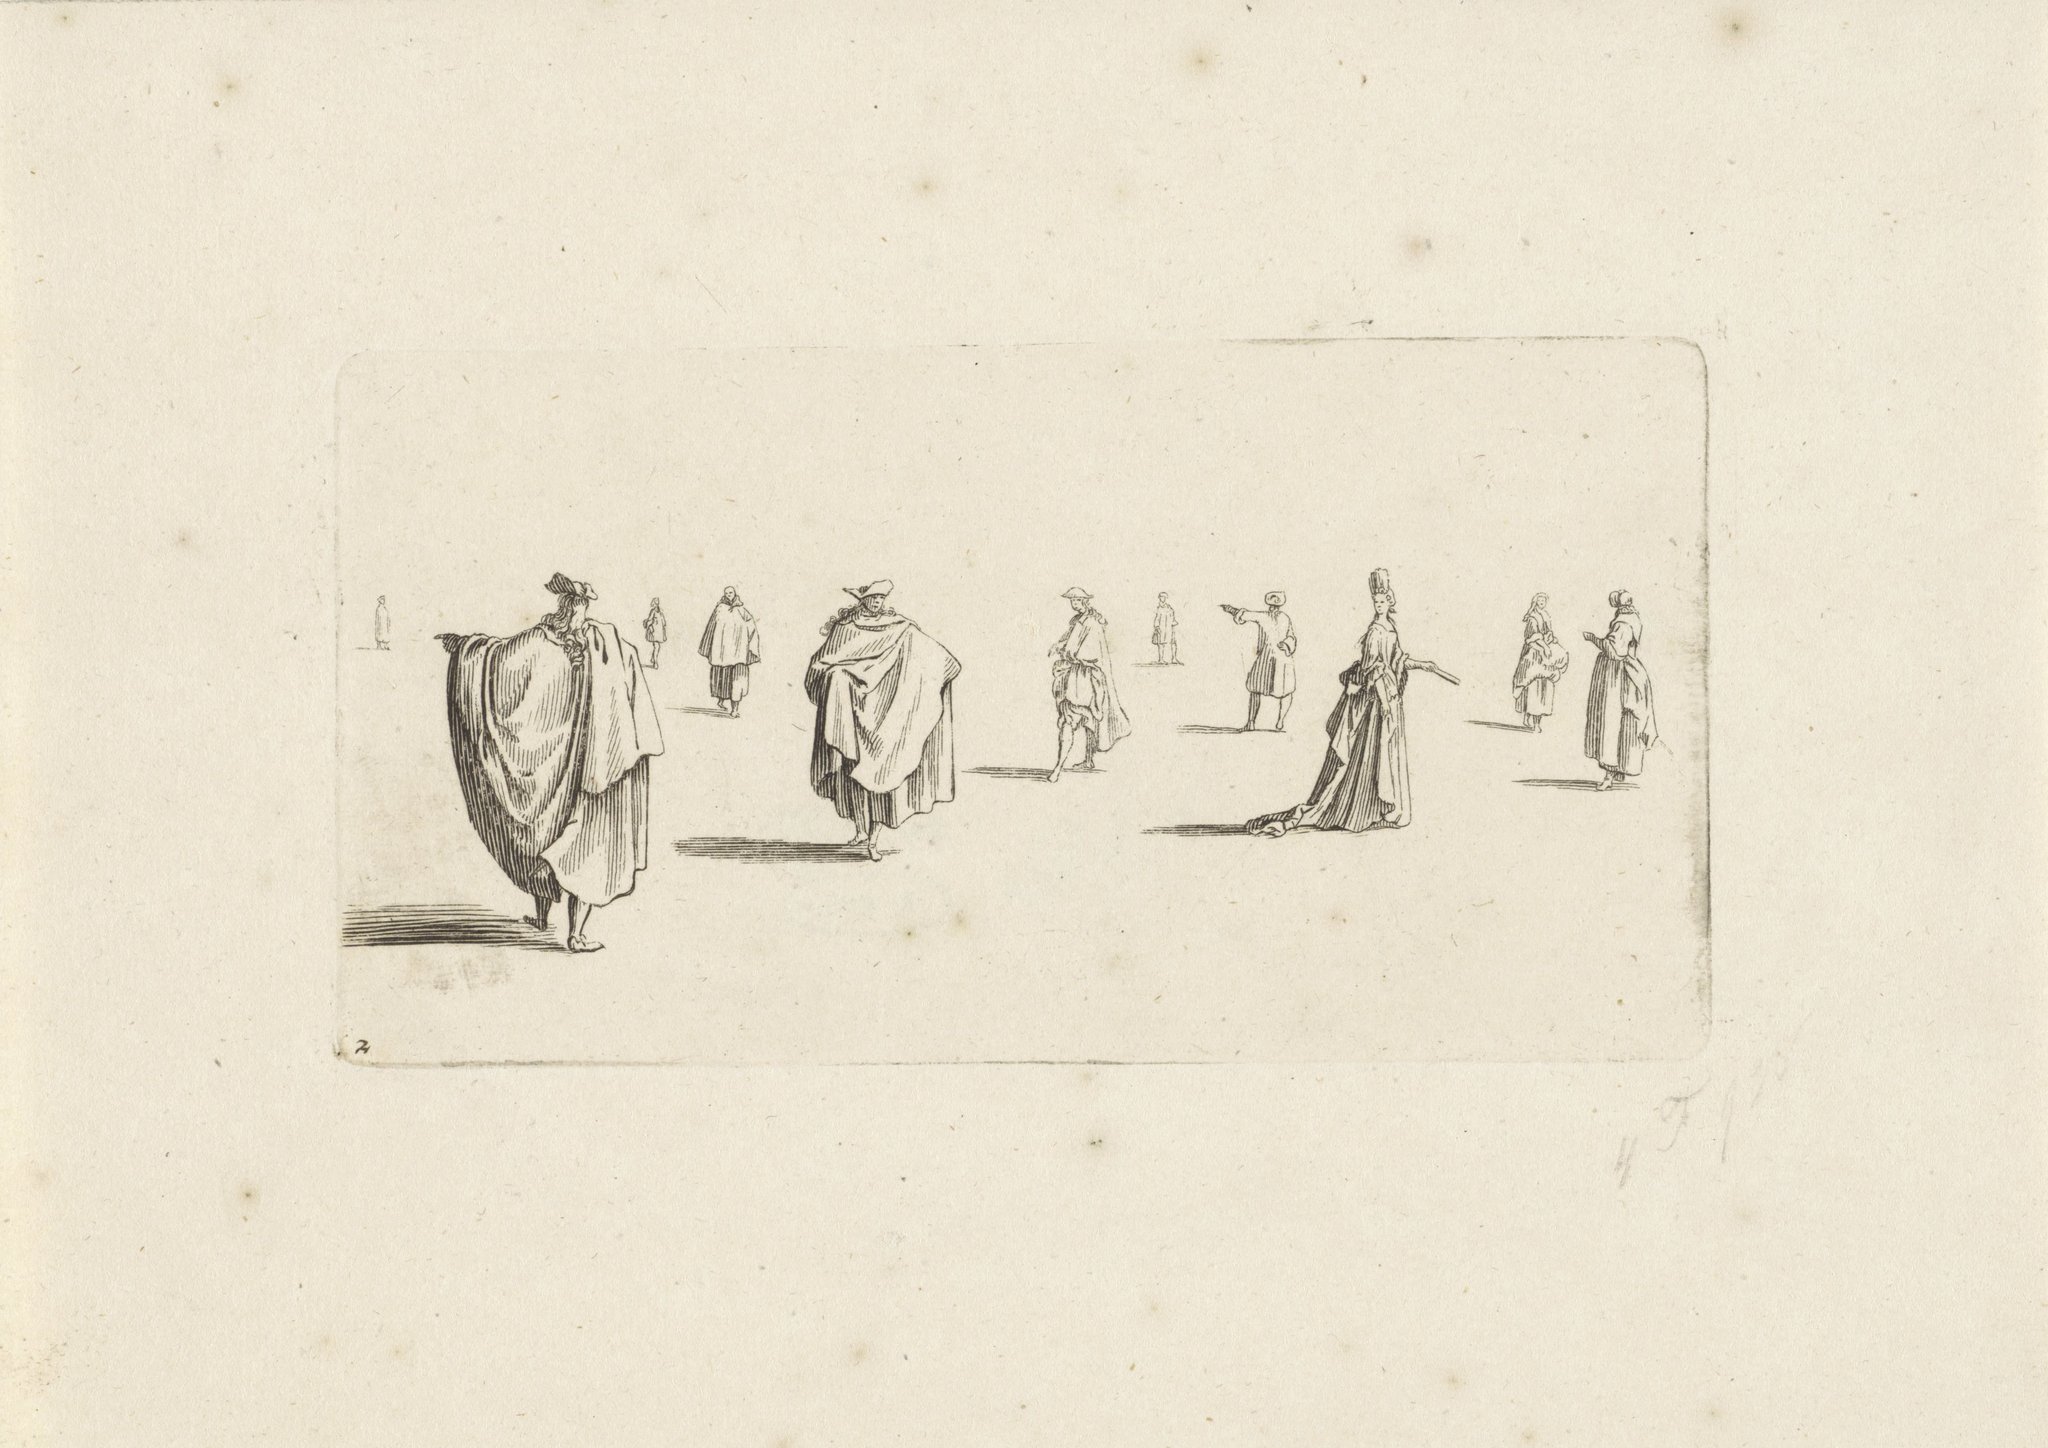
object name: print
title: Studieblad met wandelende figuren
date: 1675-1711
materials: paper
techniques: etching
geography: amsterdam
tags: human types; peoples and nationalities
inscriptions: collector's mark: Lugt 2228